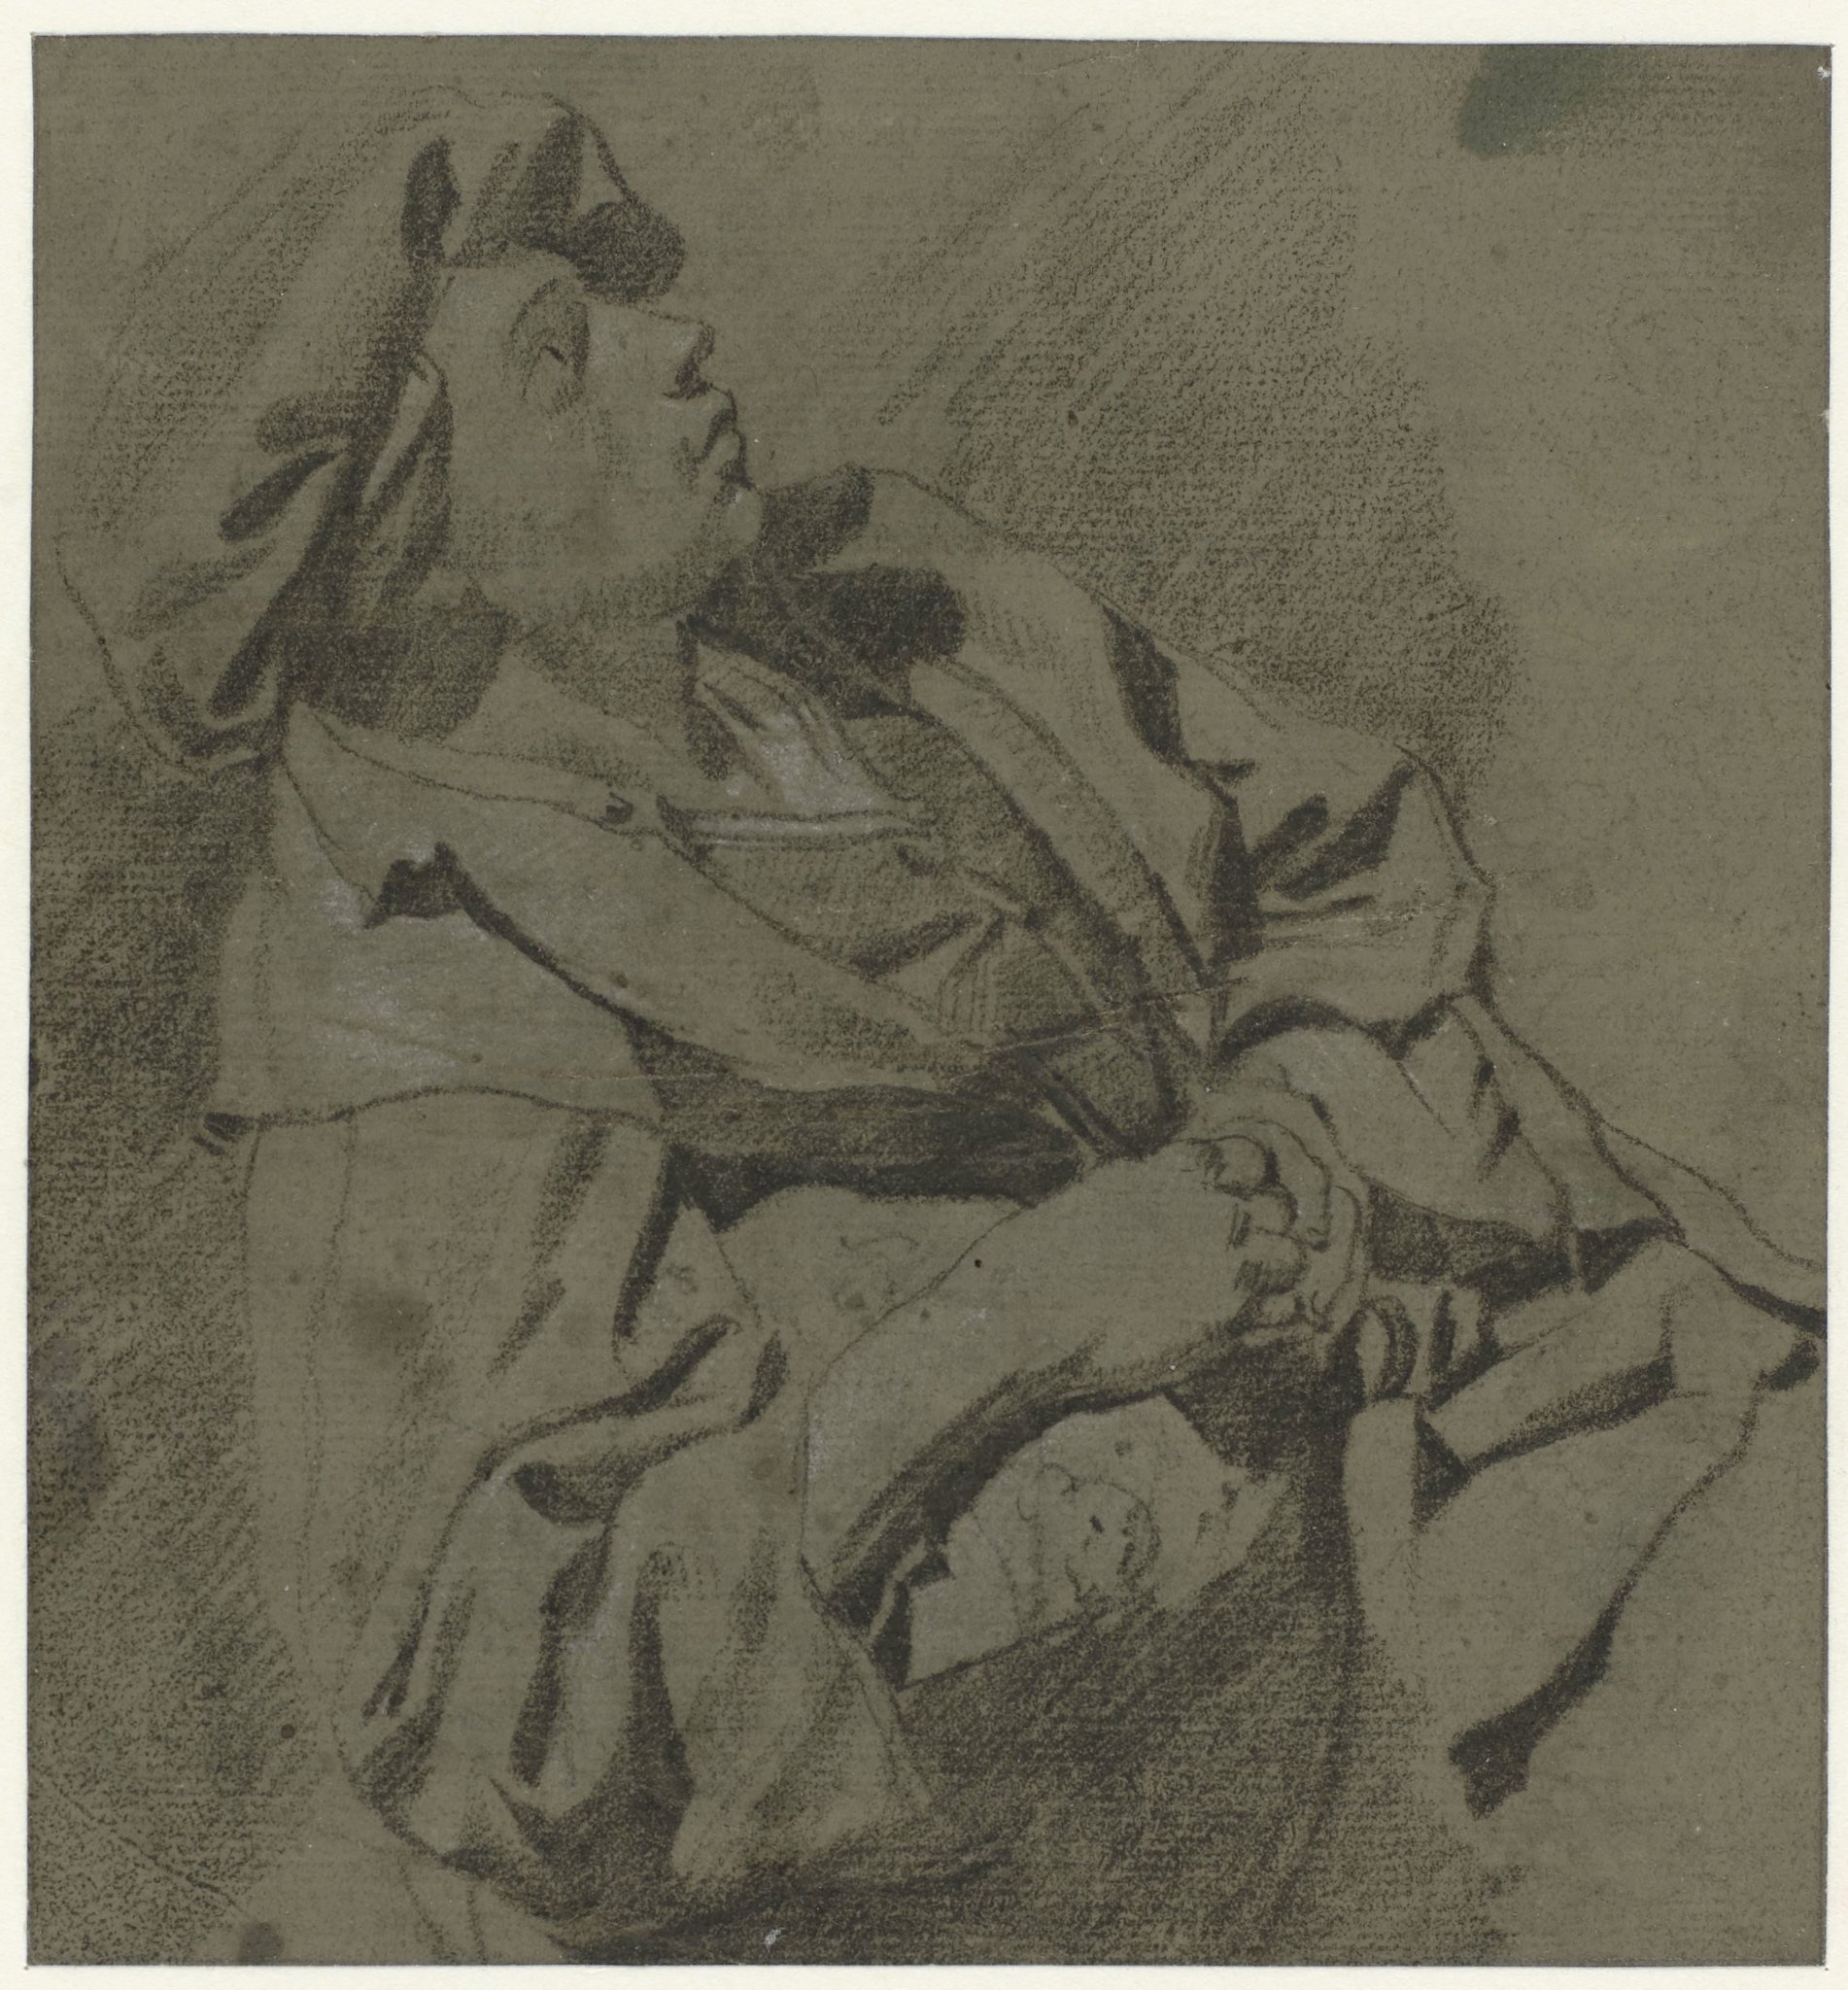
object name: drawing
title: Boy in a Beret, Leaning Back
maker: cornelis pietersz. bega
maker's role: draughtsman, painter, print maker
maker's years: 1631-1664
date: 1661-1664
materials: chalk, paper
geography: haarlem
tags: head-gear: cap (+ men's clothes)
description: Een jongeman, met platte muts op het hoofd, leunt achterover, houdt de handen gevouwen bij elkaar en kijkt omhoog.